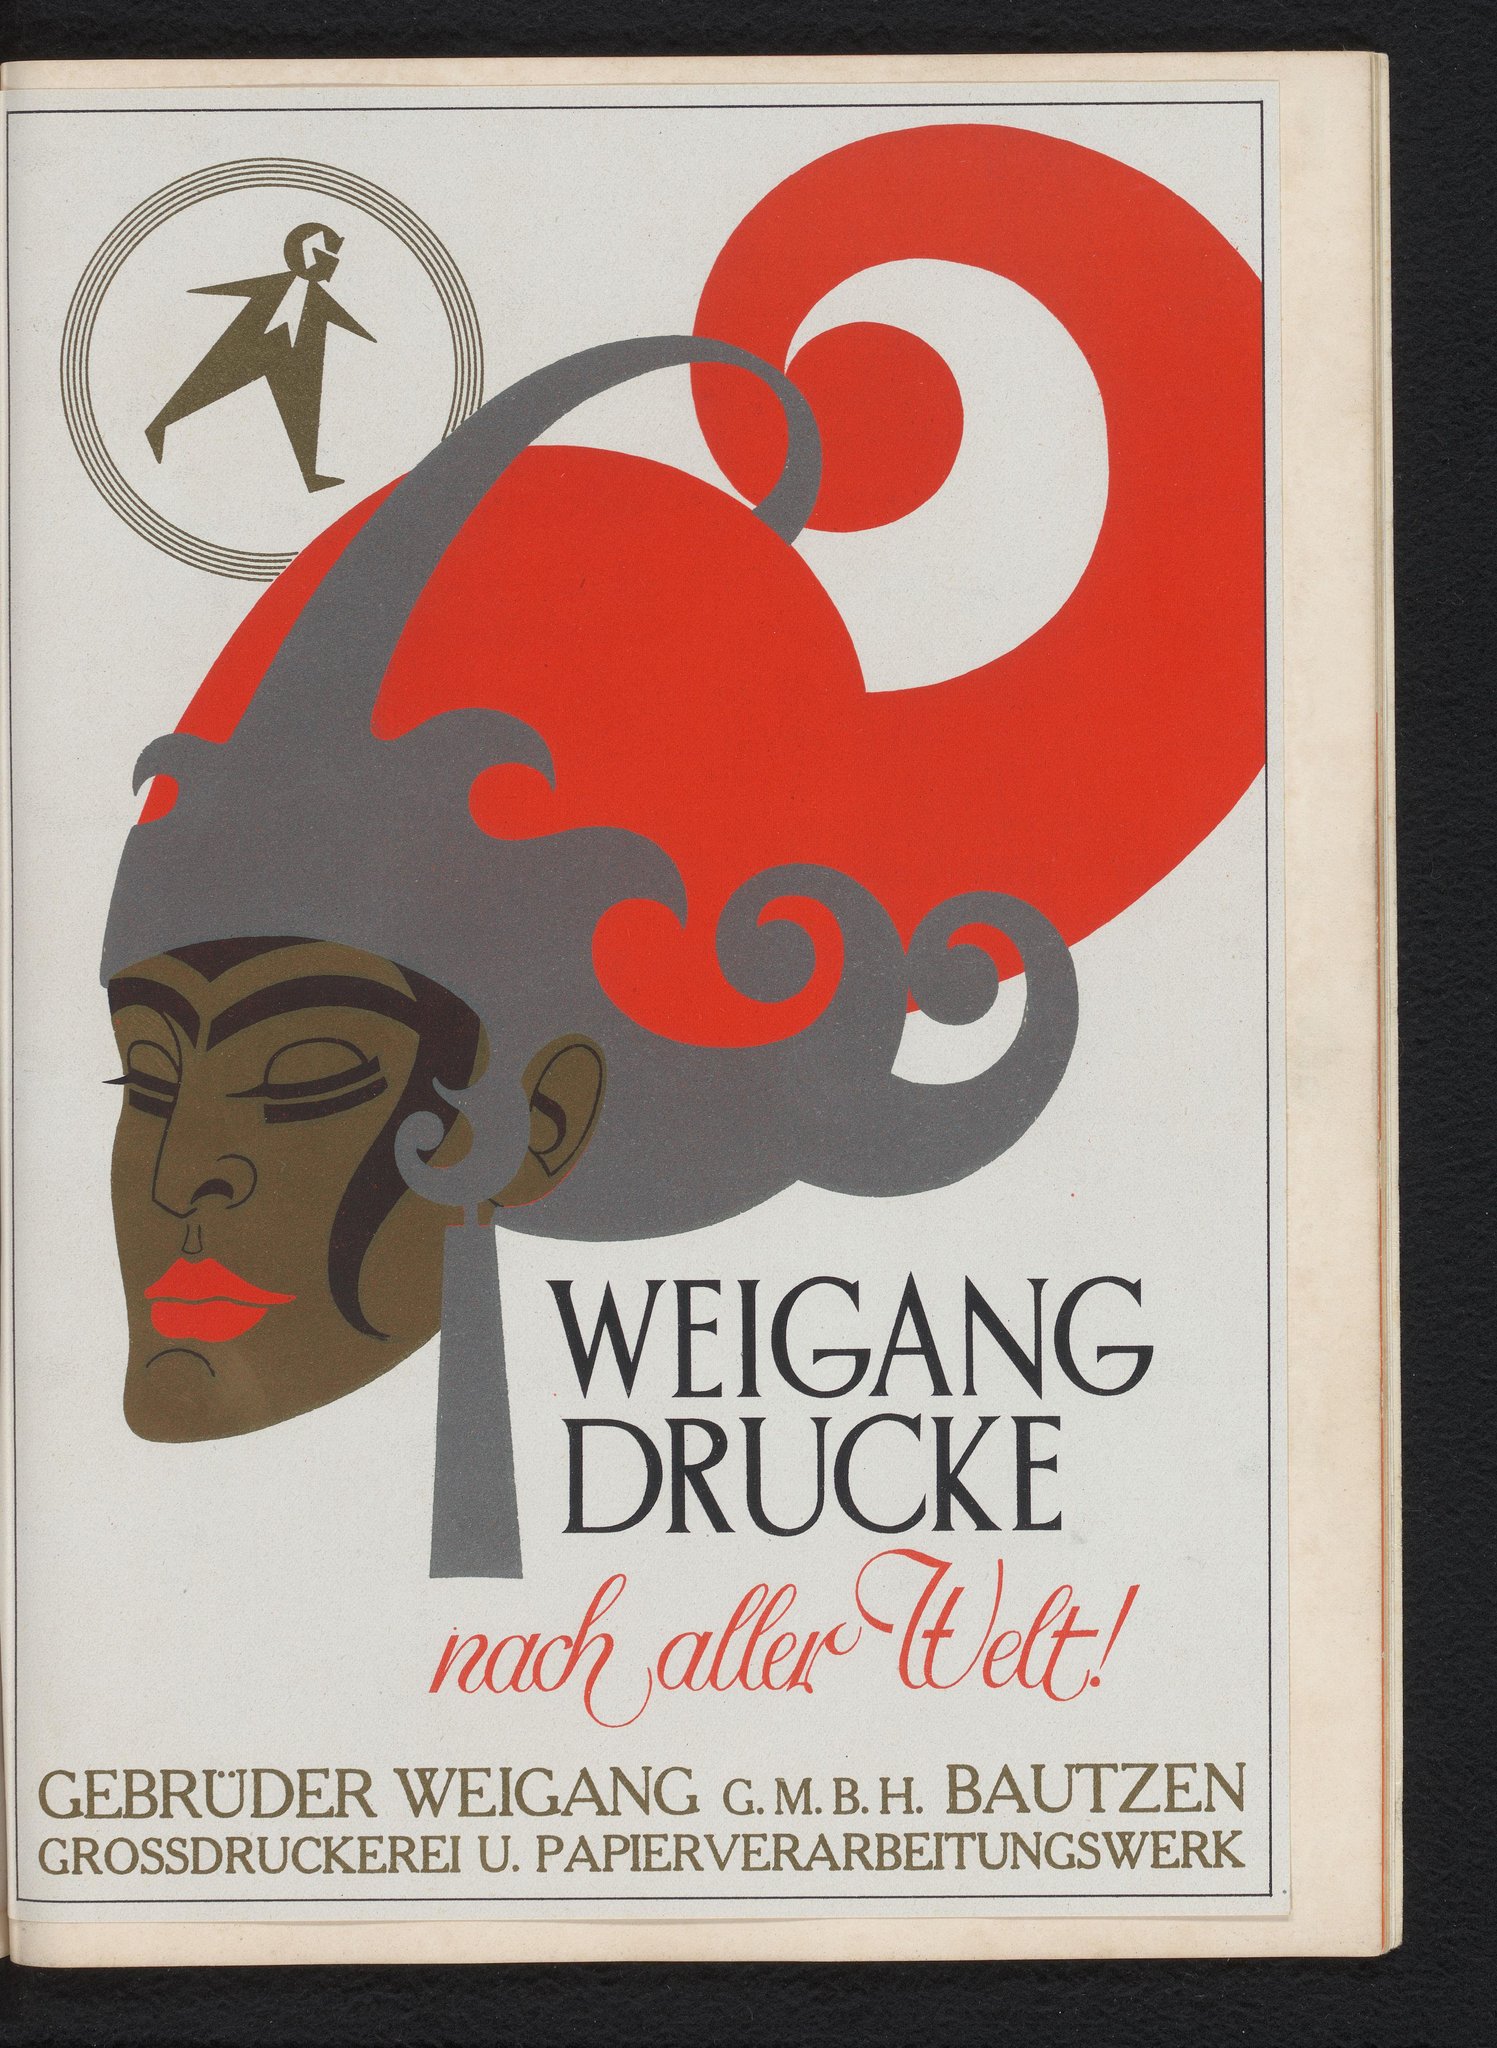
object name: print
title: Weigang Drucke nach aller Welt!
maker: Anonymous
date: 1910-1929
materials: paper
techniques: lithograph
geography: bautzen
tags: face, advertising, printer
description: Prent in: Gebrauchsgraphik, international advertising art 6 (1929), nr. 10.